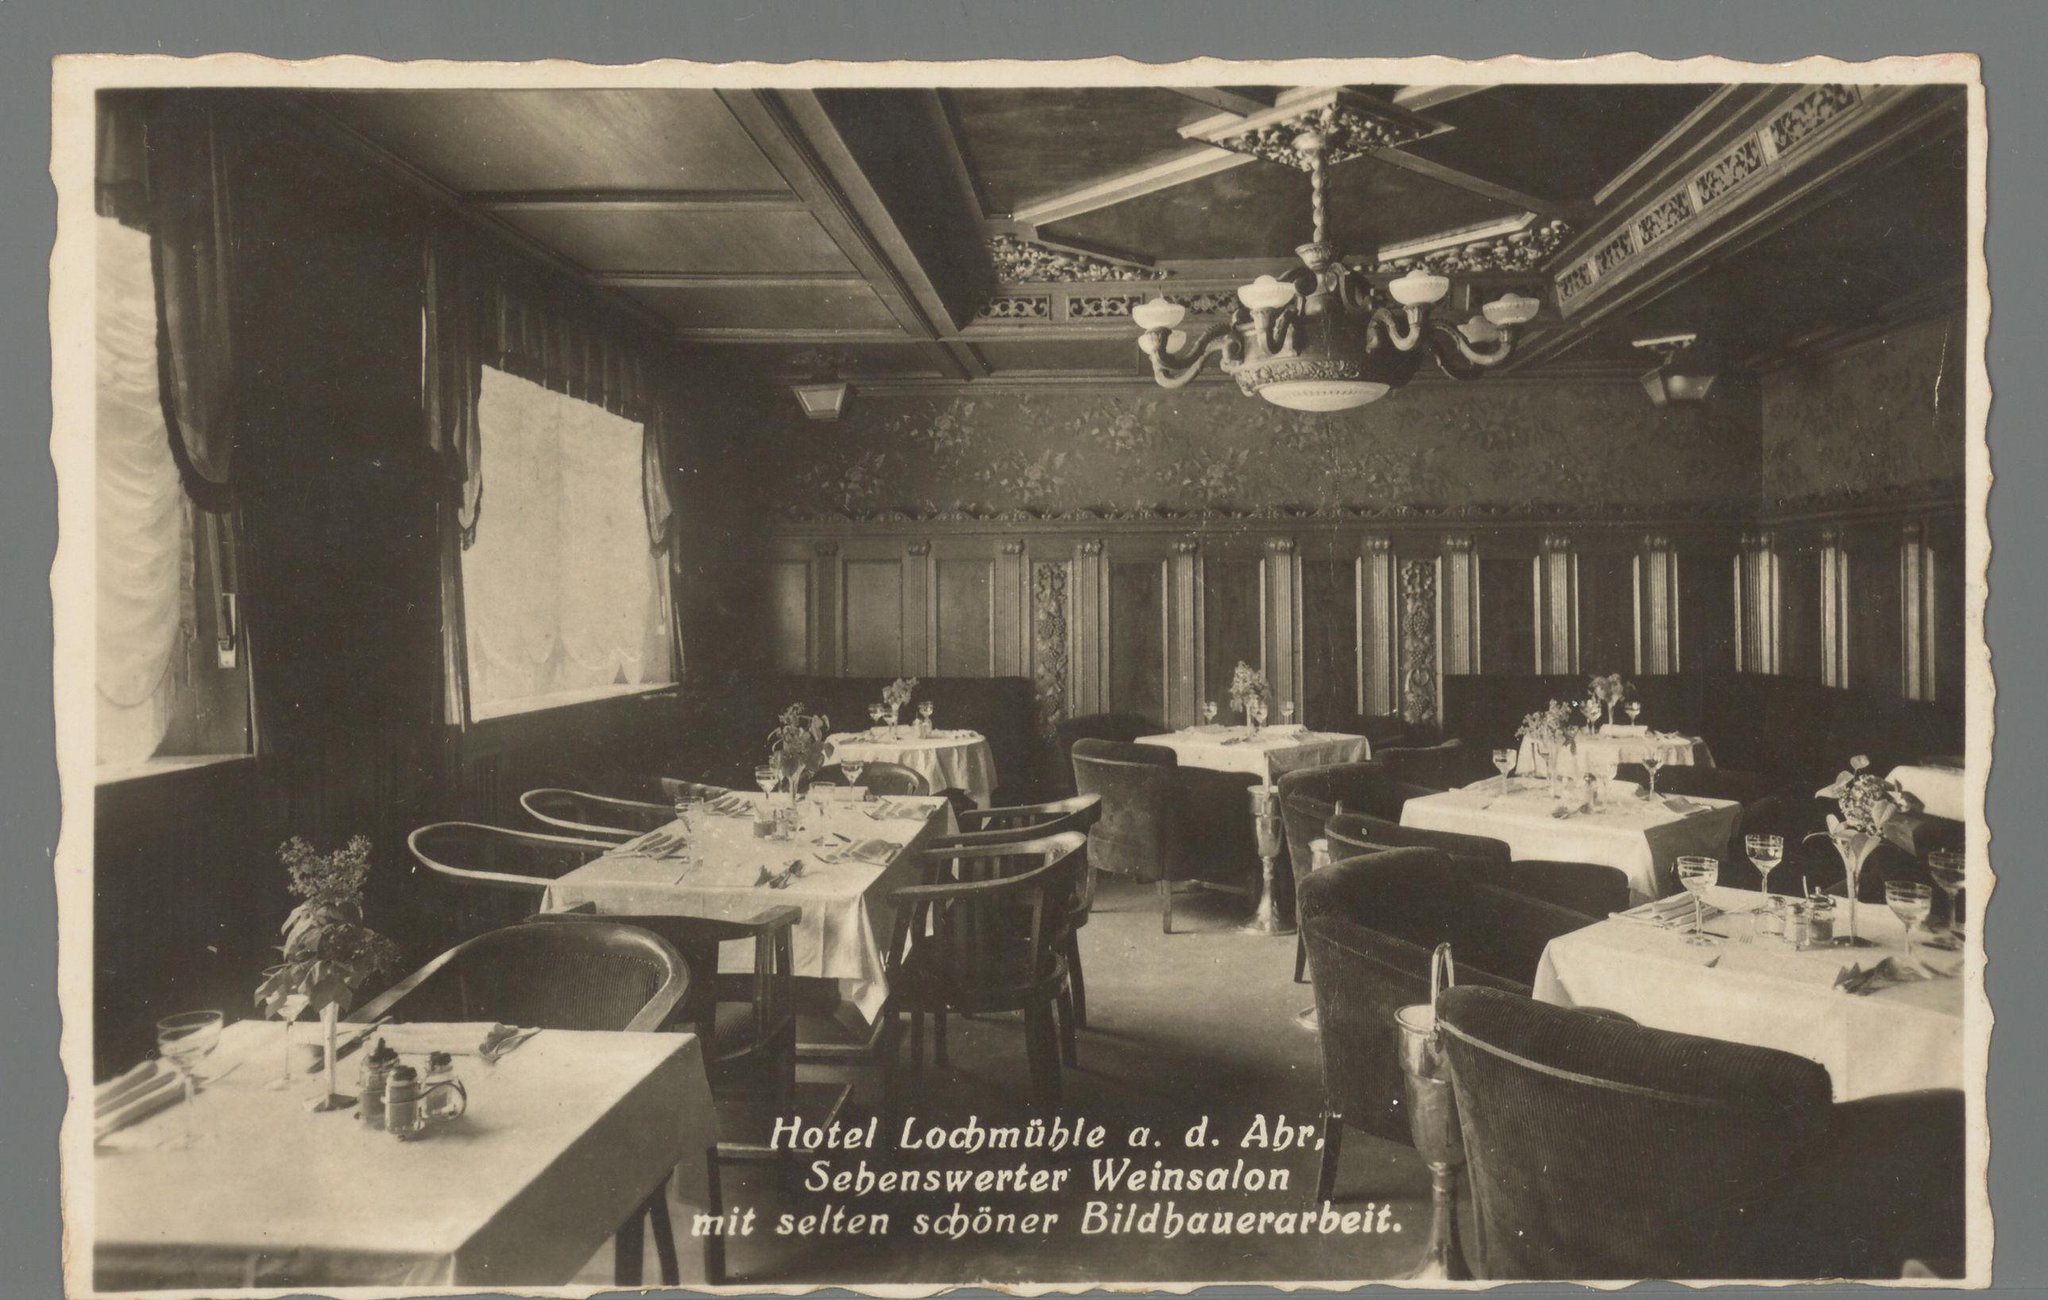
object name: ansichtkaart, prentbriefkaart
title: Hotel Lochmühle a.d. Ahr, Sehenswerter Weinsalon met selten schöner Bildhauerarbeit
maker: Anonymous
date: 1930-1932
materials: photographic support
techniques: photography, writing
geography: ahrtal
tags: interior of the house, hotel, hostelry, inn